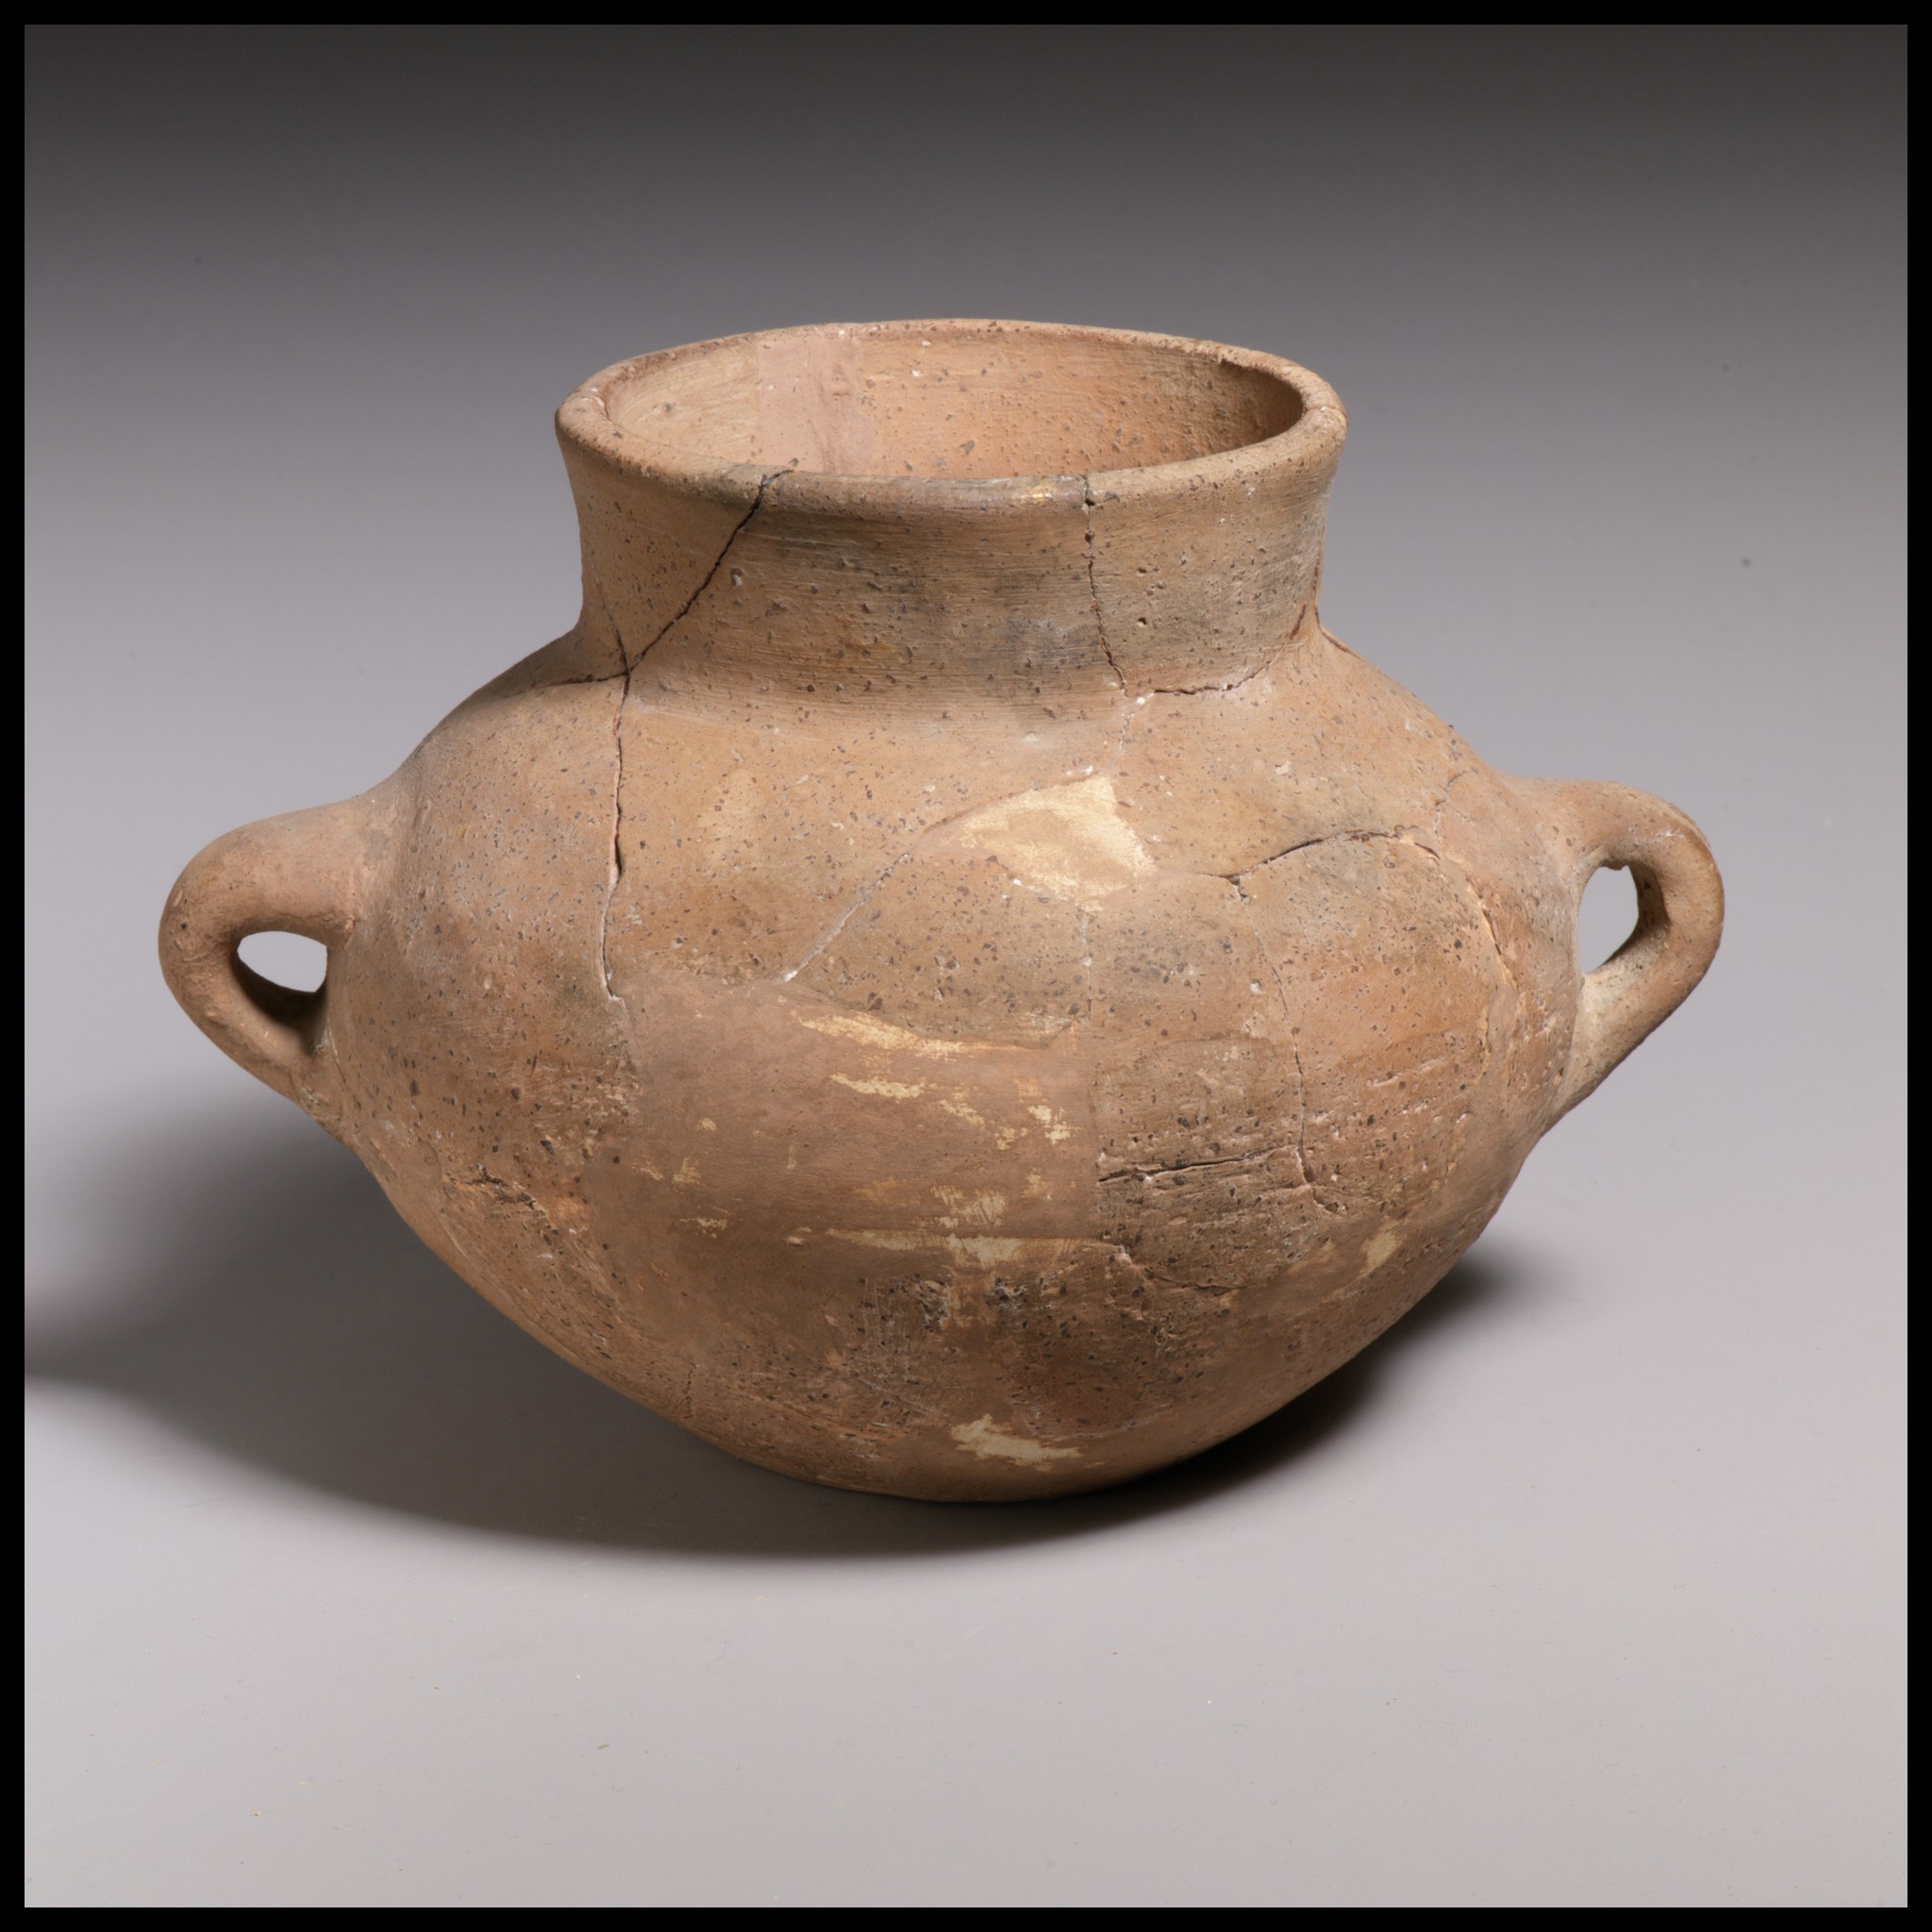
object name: jar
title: Terracotta collar-necked jar with two handles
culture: helladic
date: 2650-2150 BCE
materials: terracotta